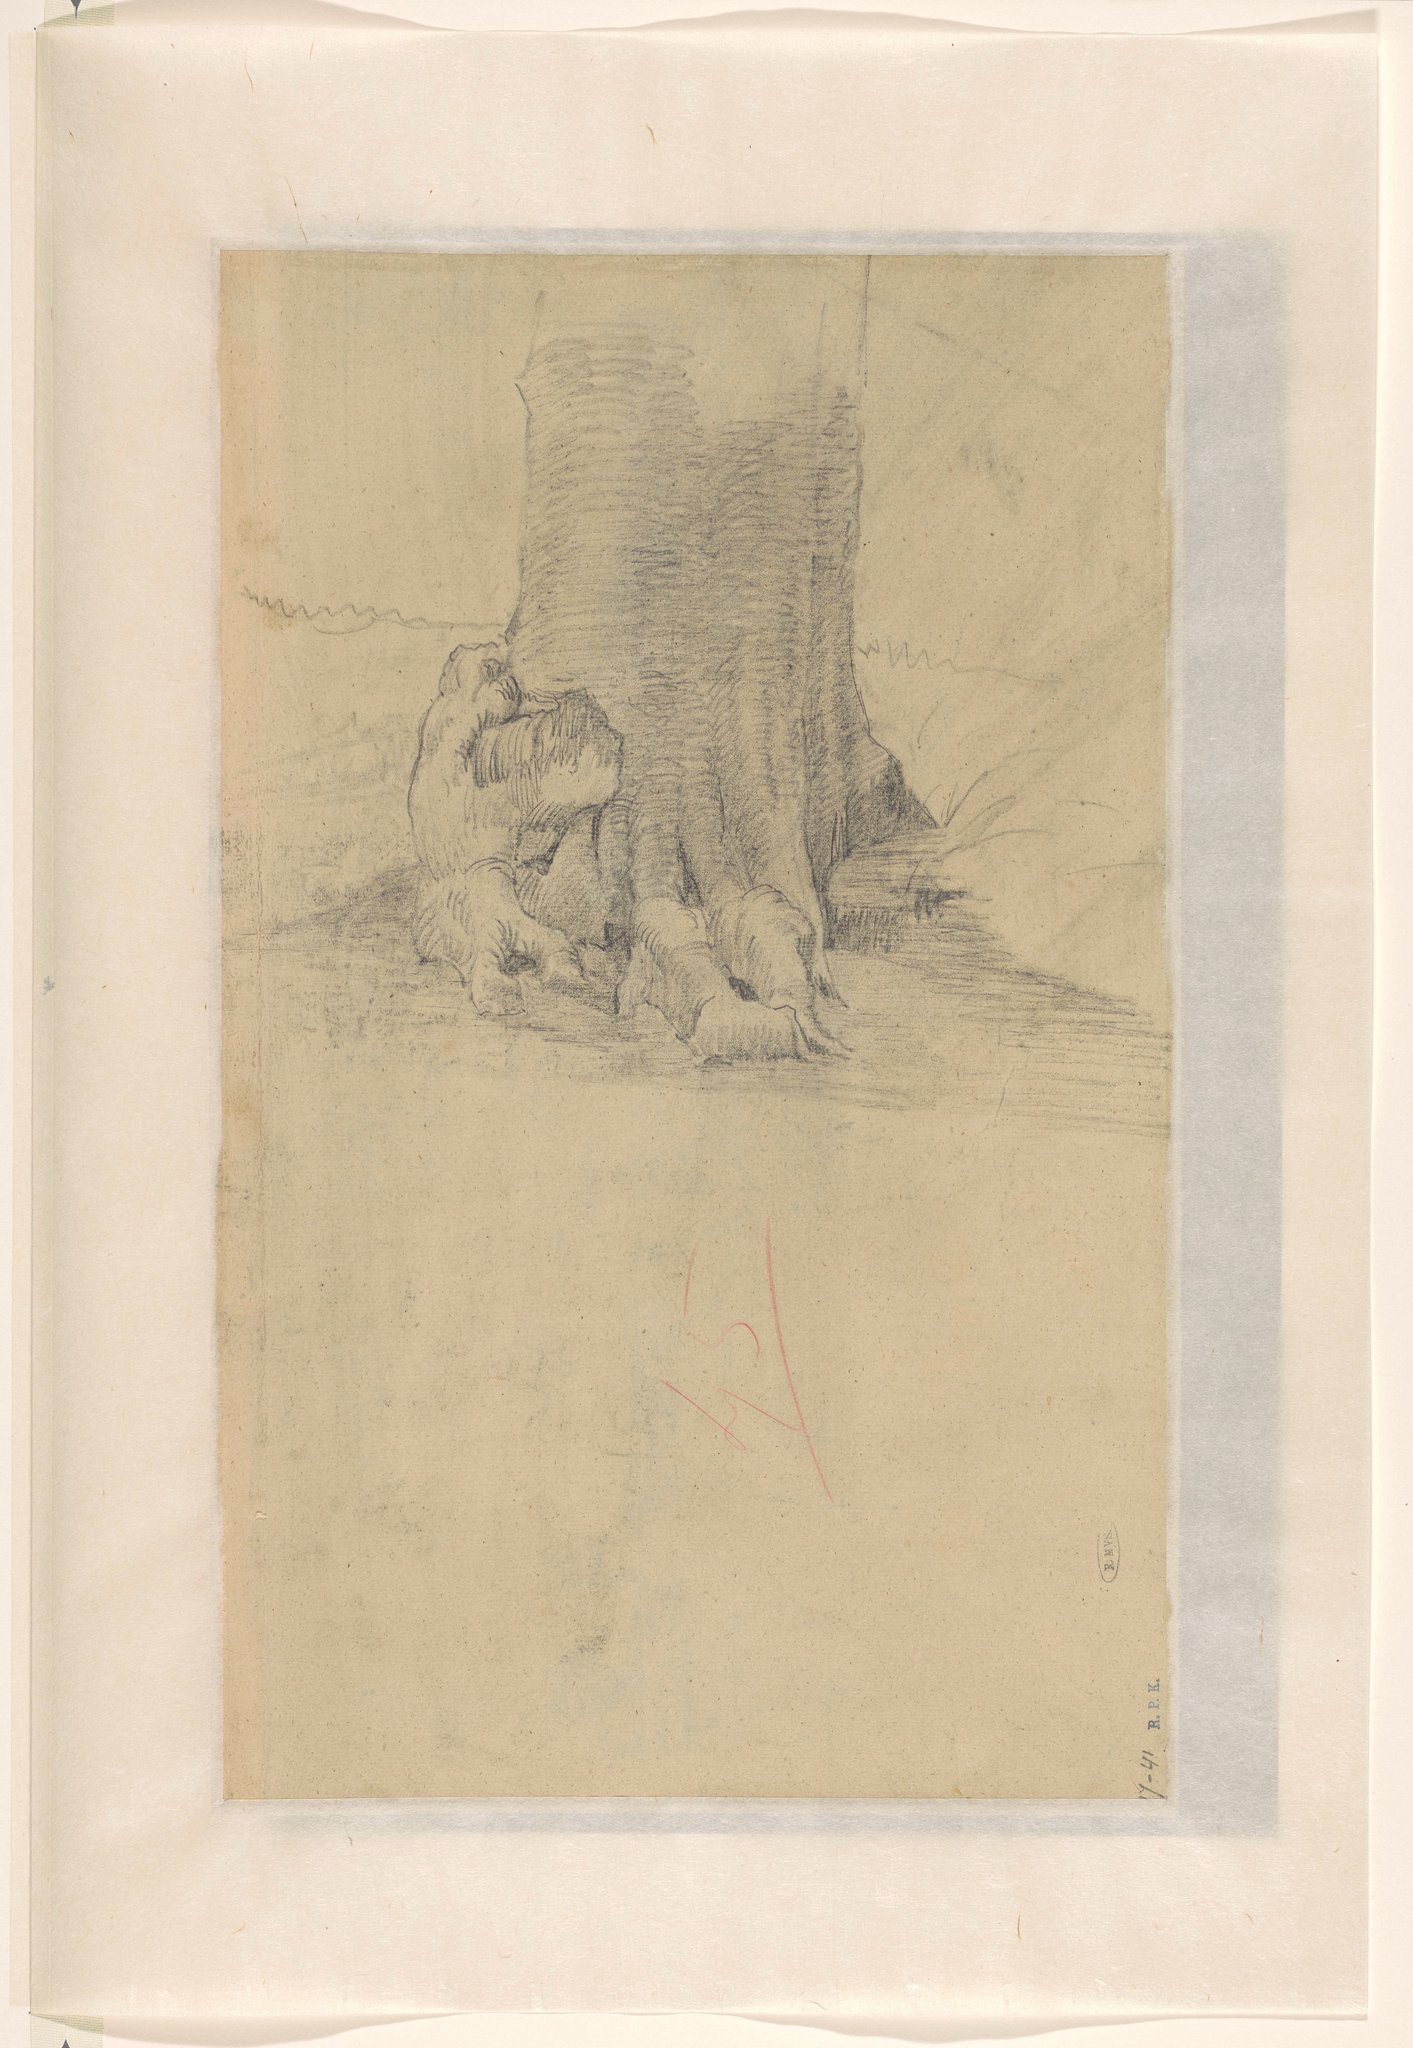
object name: drawing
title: Studie van de wortels van een boom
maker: anton mauve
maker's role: draughtsman, painter, print maker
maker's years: 1838-1888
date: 1848-1888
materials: paper, pencil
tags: trees